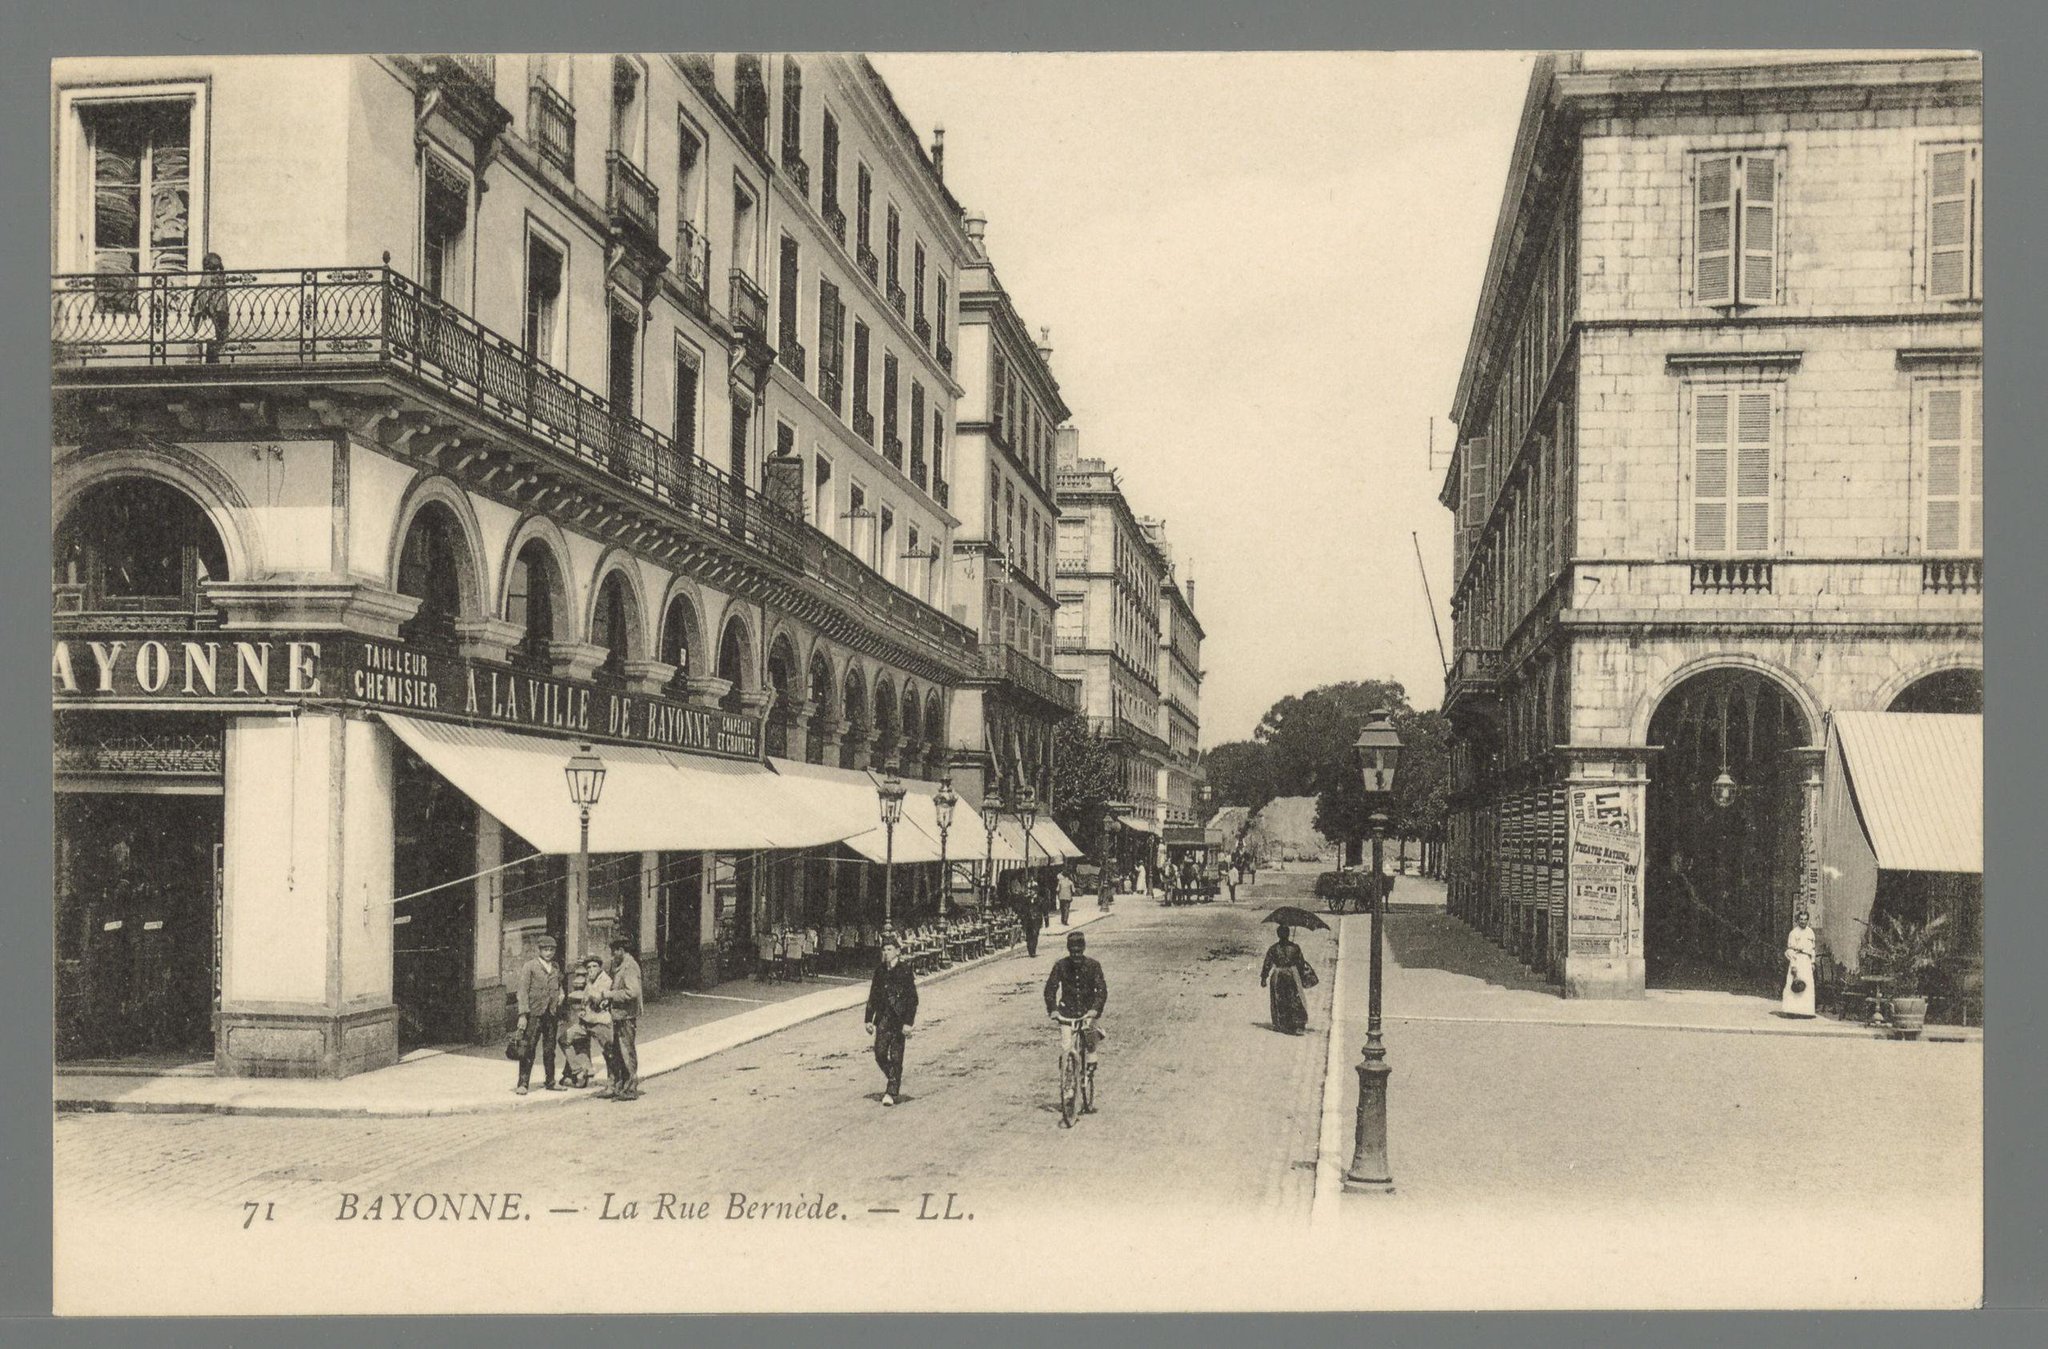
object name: photomechanical print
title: Bayonne. La Rue Bernède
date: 1903-1908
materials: cardboard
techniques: photograph, writing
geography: paris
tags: urban housing, street (+ city(-scape) with figures, staffage)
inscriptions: inscription: ‘29-03-08’